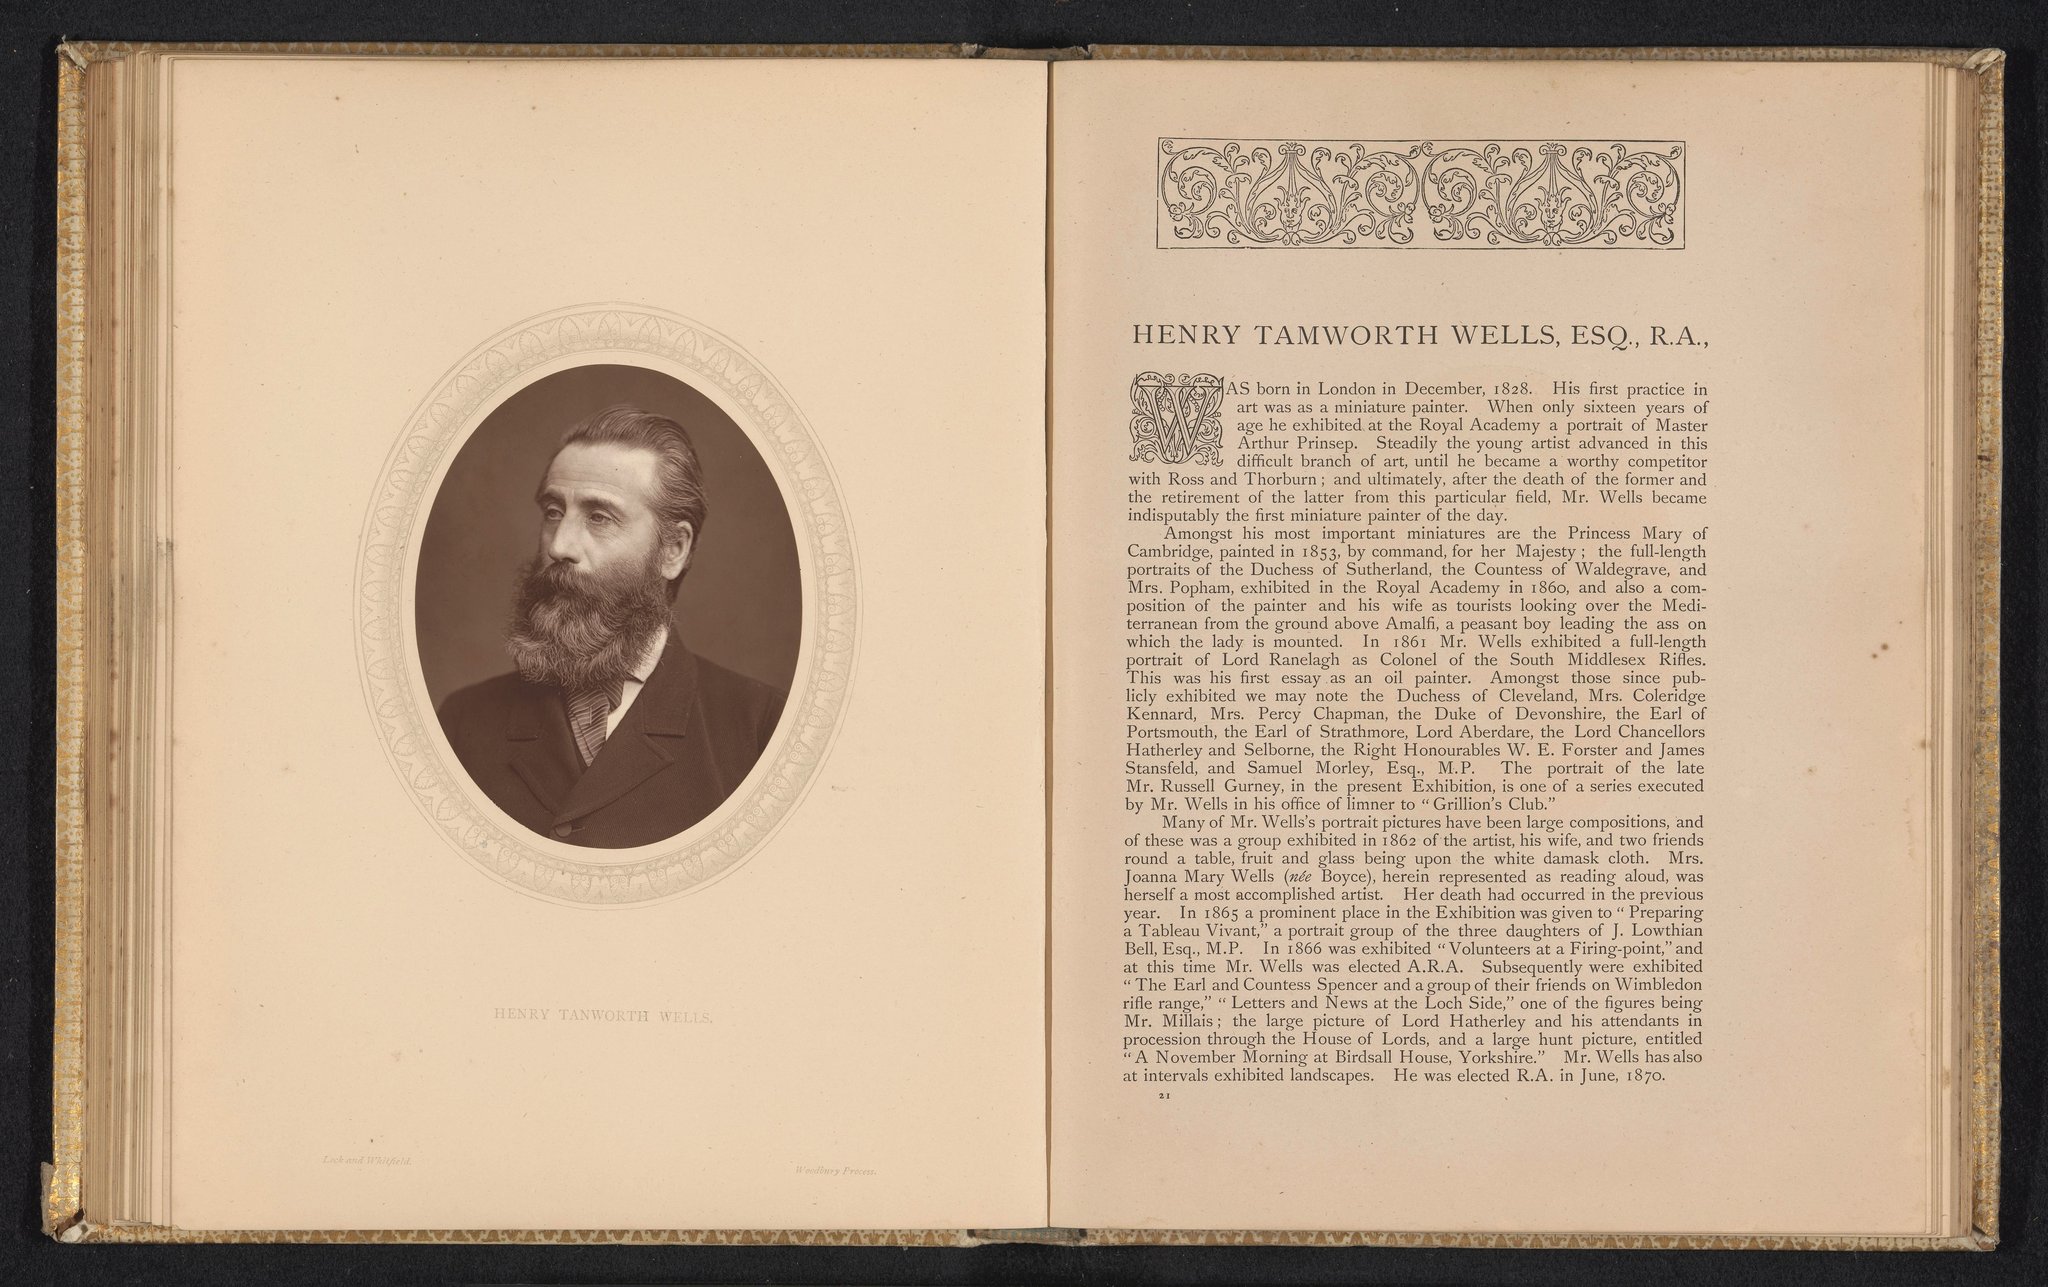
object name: photomechanical print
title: Henry Tanworth Wells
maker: Anonymous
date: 1873-1878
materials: paper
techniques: woodburytype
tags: portrait, self-portrait of painter, historical persons (portraits and scenes from the life) (+ (full) bust portrait)